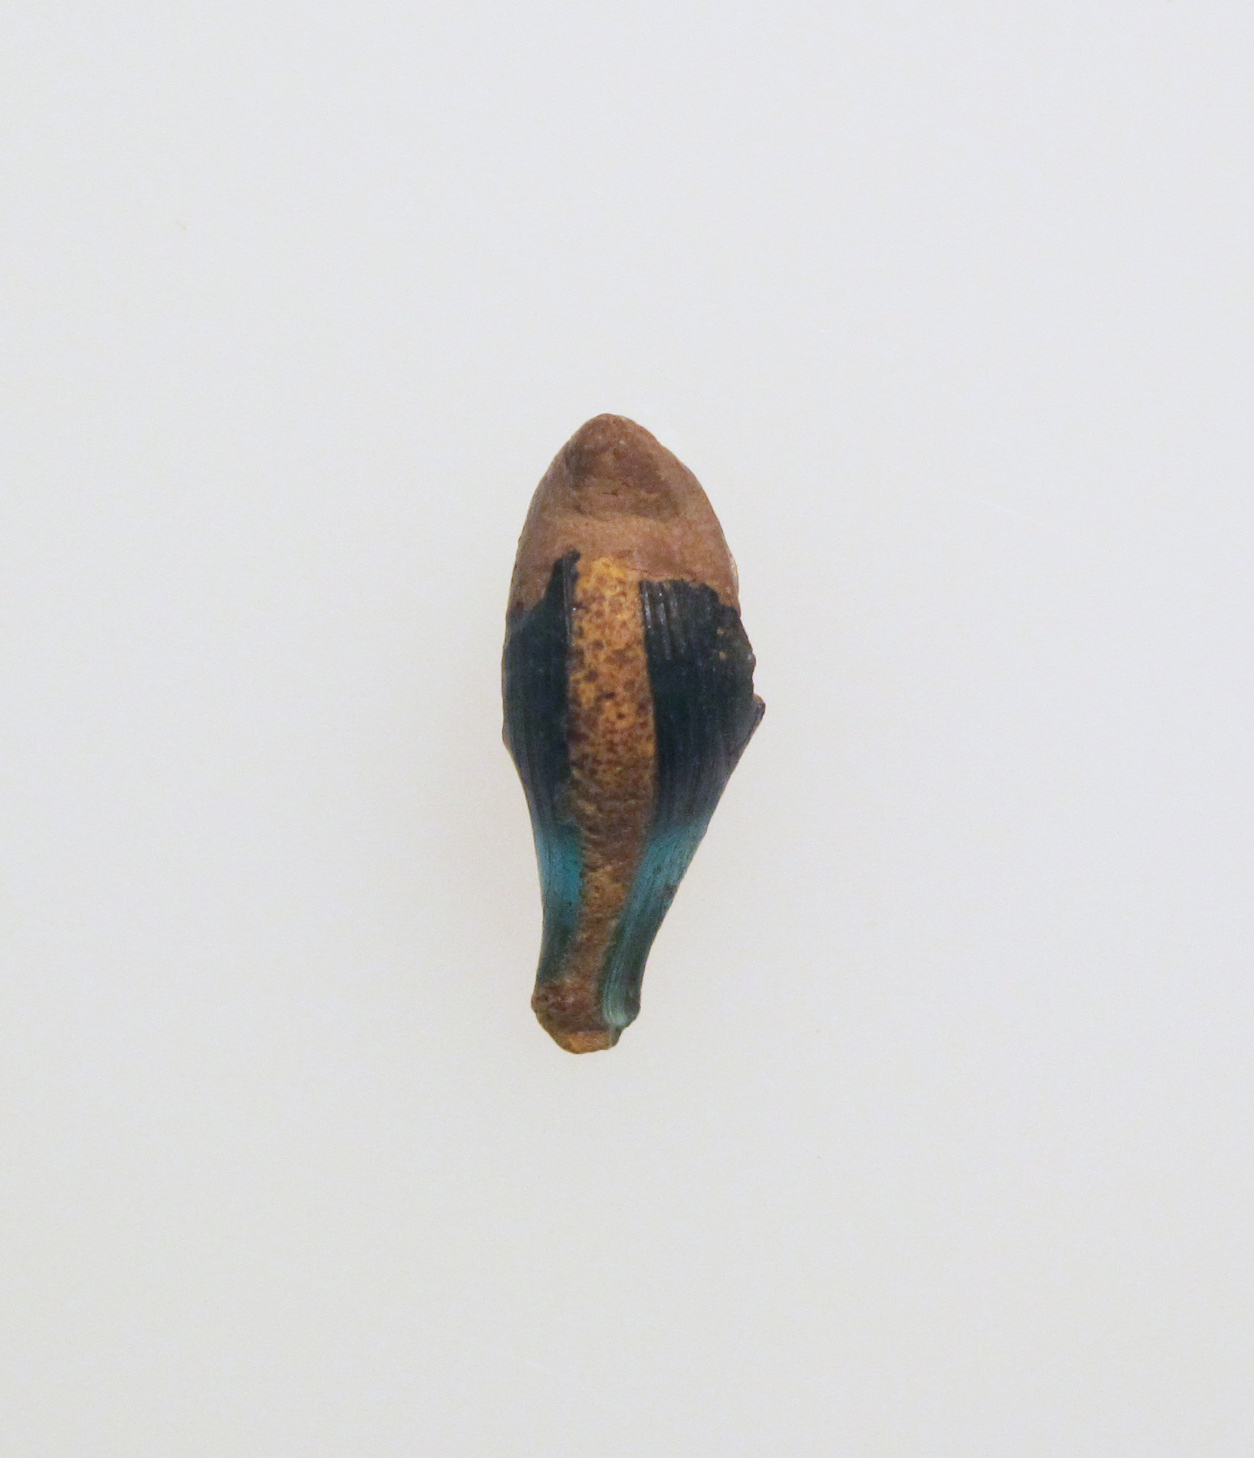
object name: pendant in the form of a dolphin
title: Glass pendant in the form of a dolphin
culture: roman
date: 670 BCE-330 CE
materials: glass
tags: dolphins